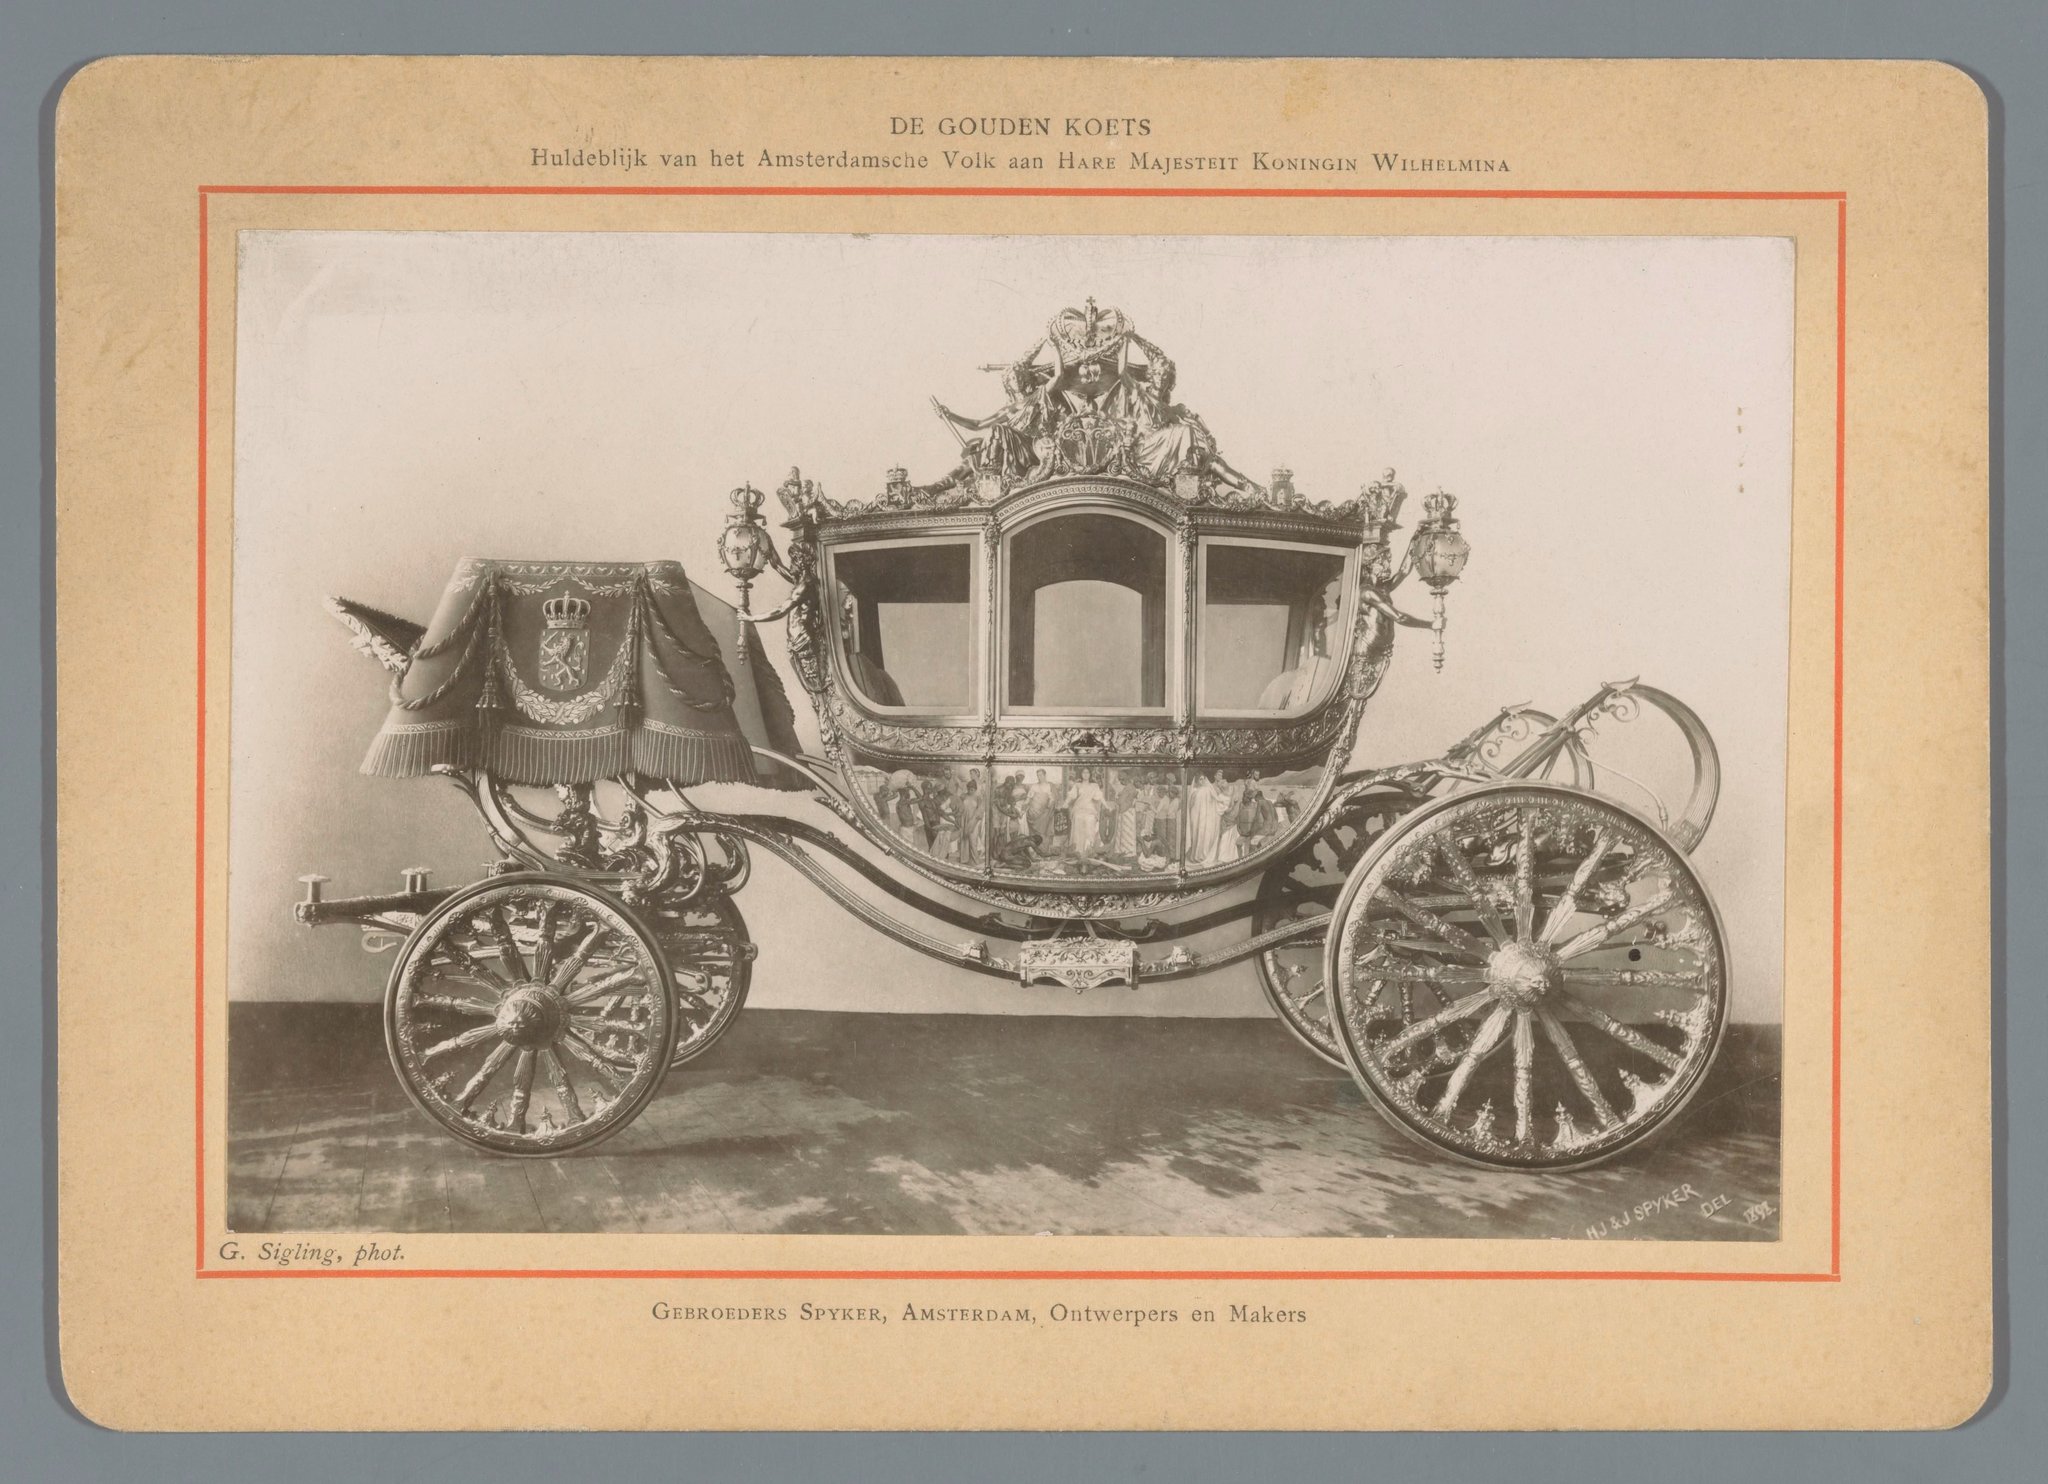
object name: cabinet photograph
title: Gouden Koets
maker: georg sigling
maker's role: draughtsman, painter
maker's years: 1854-1918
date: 1809-1898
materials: cardboard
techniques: collodion silver print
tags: four-wheeled, animal-drawn vehicle, e.g.: cab, carriage, coach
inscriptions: inscription: ‘Geschenk van Amsterdam bij de Inhuldiging in Sept. '98./ Gebruikt bij het trouwen 7.2.1901 en 3 keer bij de/ Maartfeesten in Amsterdam. (2 keer met electrisch/ licht).’, inscription: ‘GEBROEDERS SPYKER, AMSTERDAM, Ontwerpers en Makers’, inscription: ‘H J & J SPYKER/ DEL/ 1898’